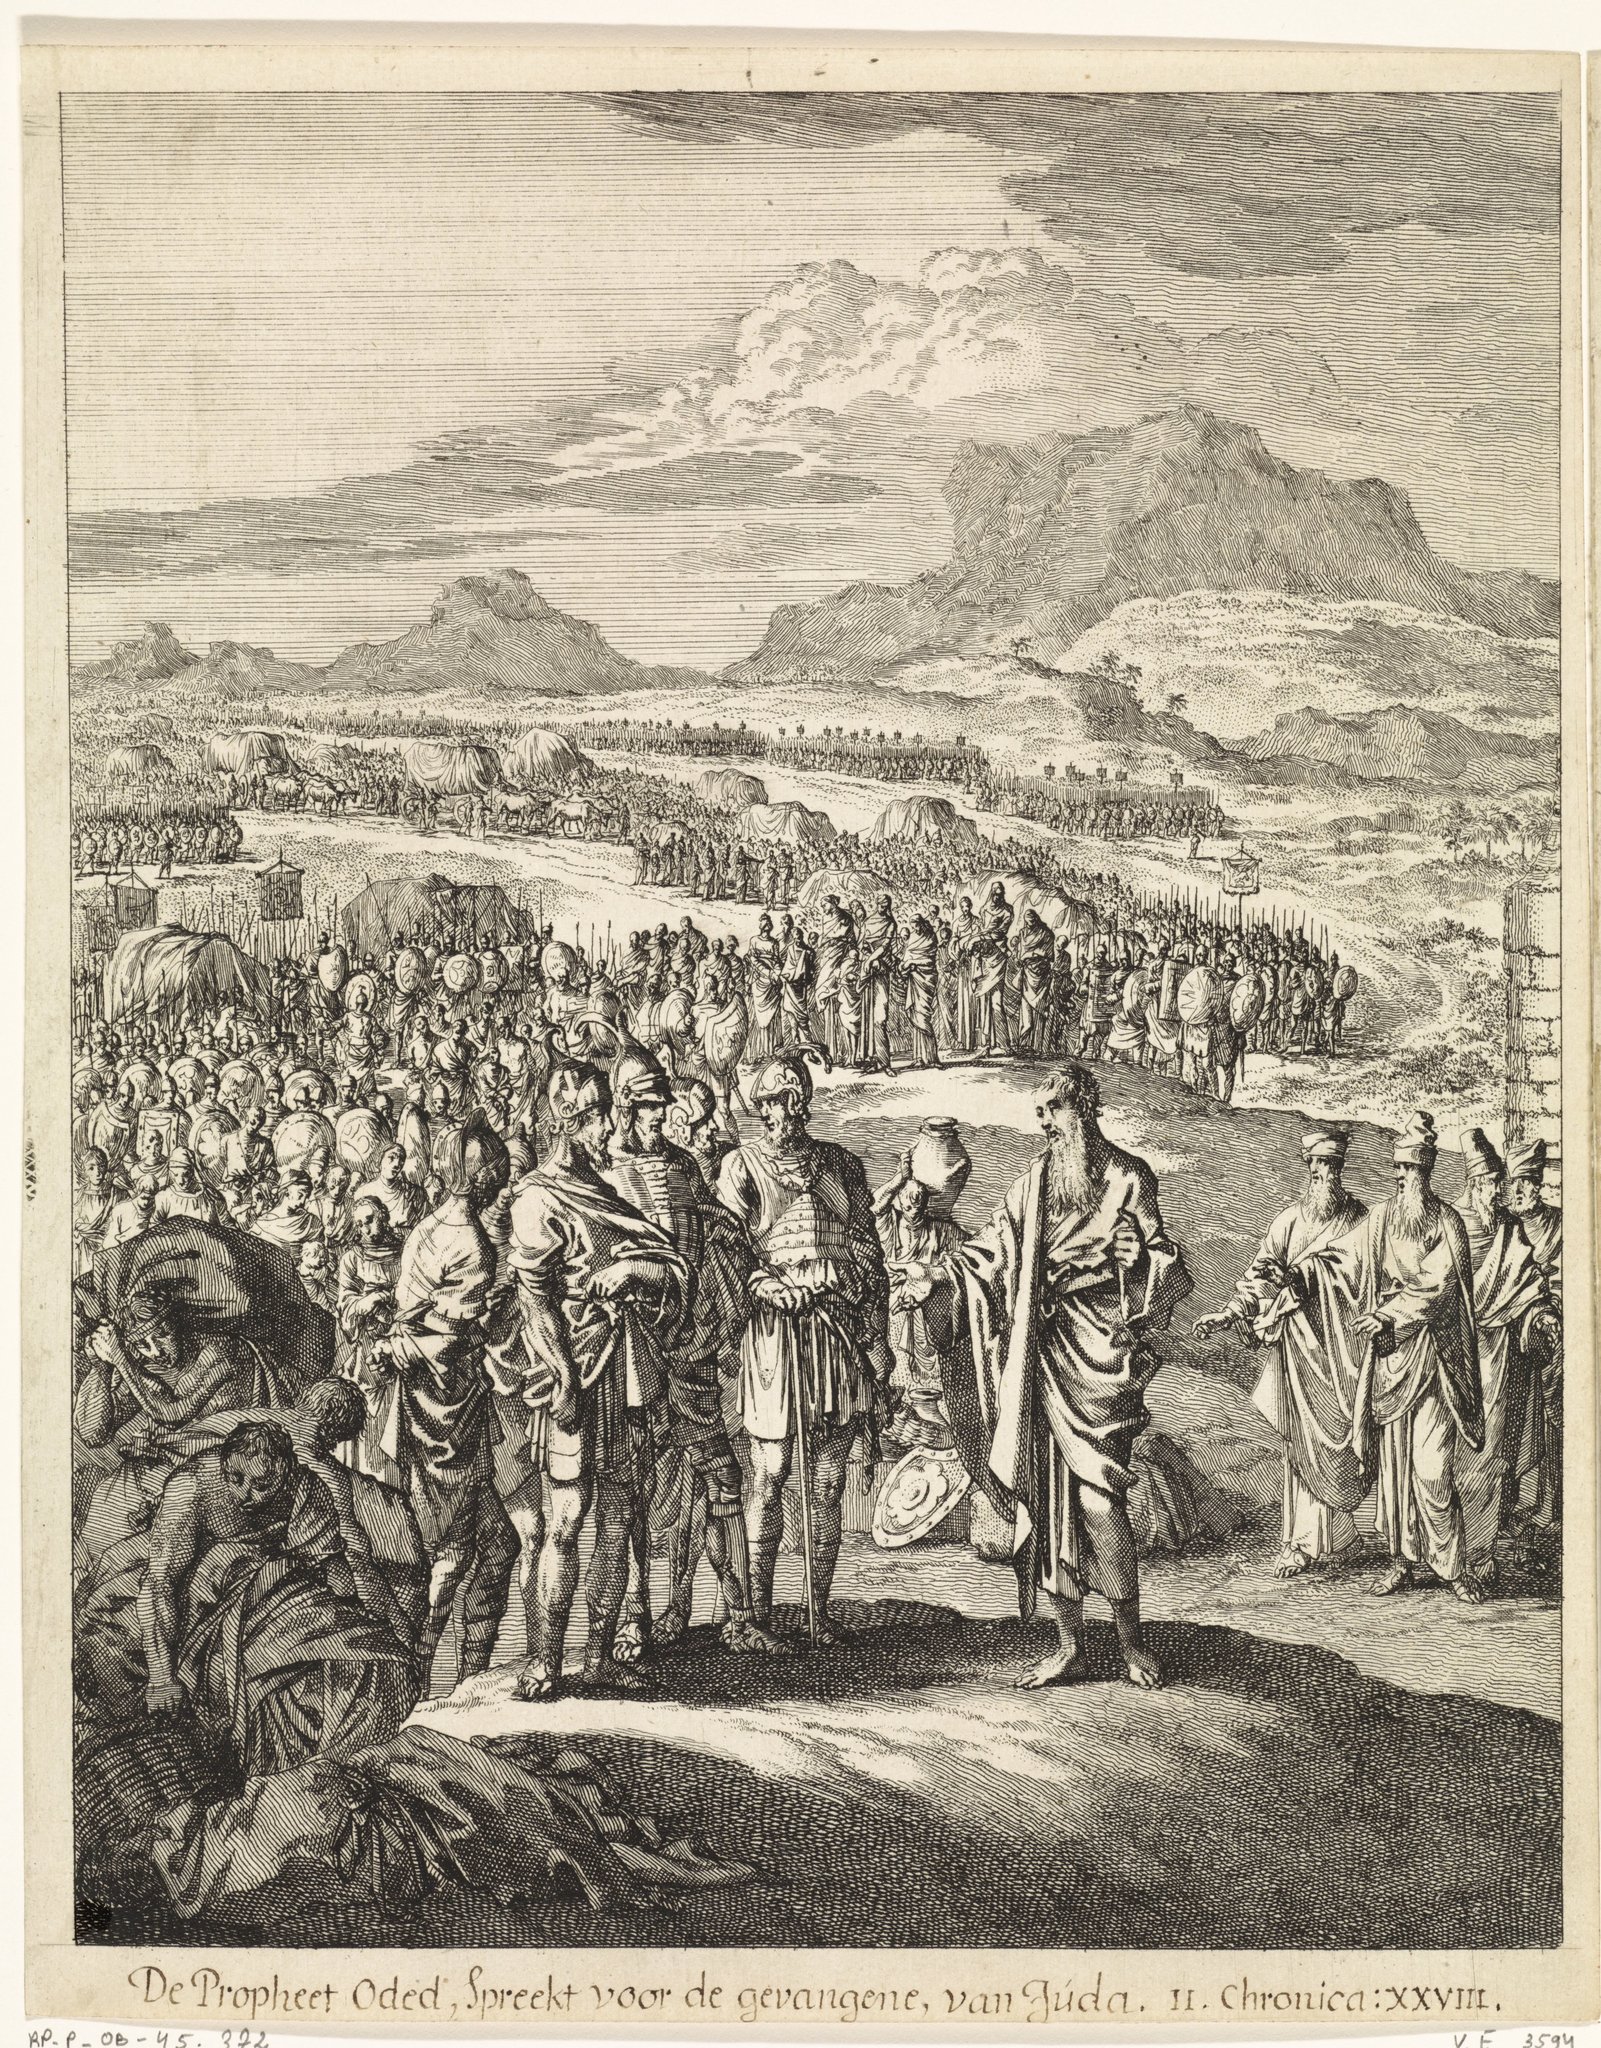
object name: print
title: Oded bij het leger van de Israëlieten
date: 1708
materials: paper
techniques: etching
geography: amsterdam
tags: oded, a prophet, meets the returning israelite army with the judaean prisoners and exhorts the israelites to let the prisoners go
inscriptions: collector's mark: Lugt 2228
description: Proefdruk van een prent welke is opgenomen als illustratie in: Historiae Celebriores Veteris Testamenti. Christoph Weigel, 1708.